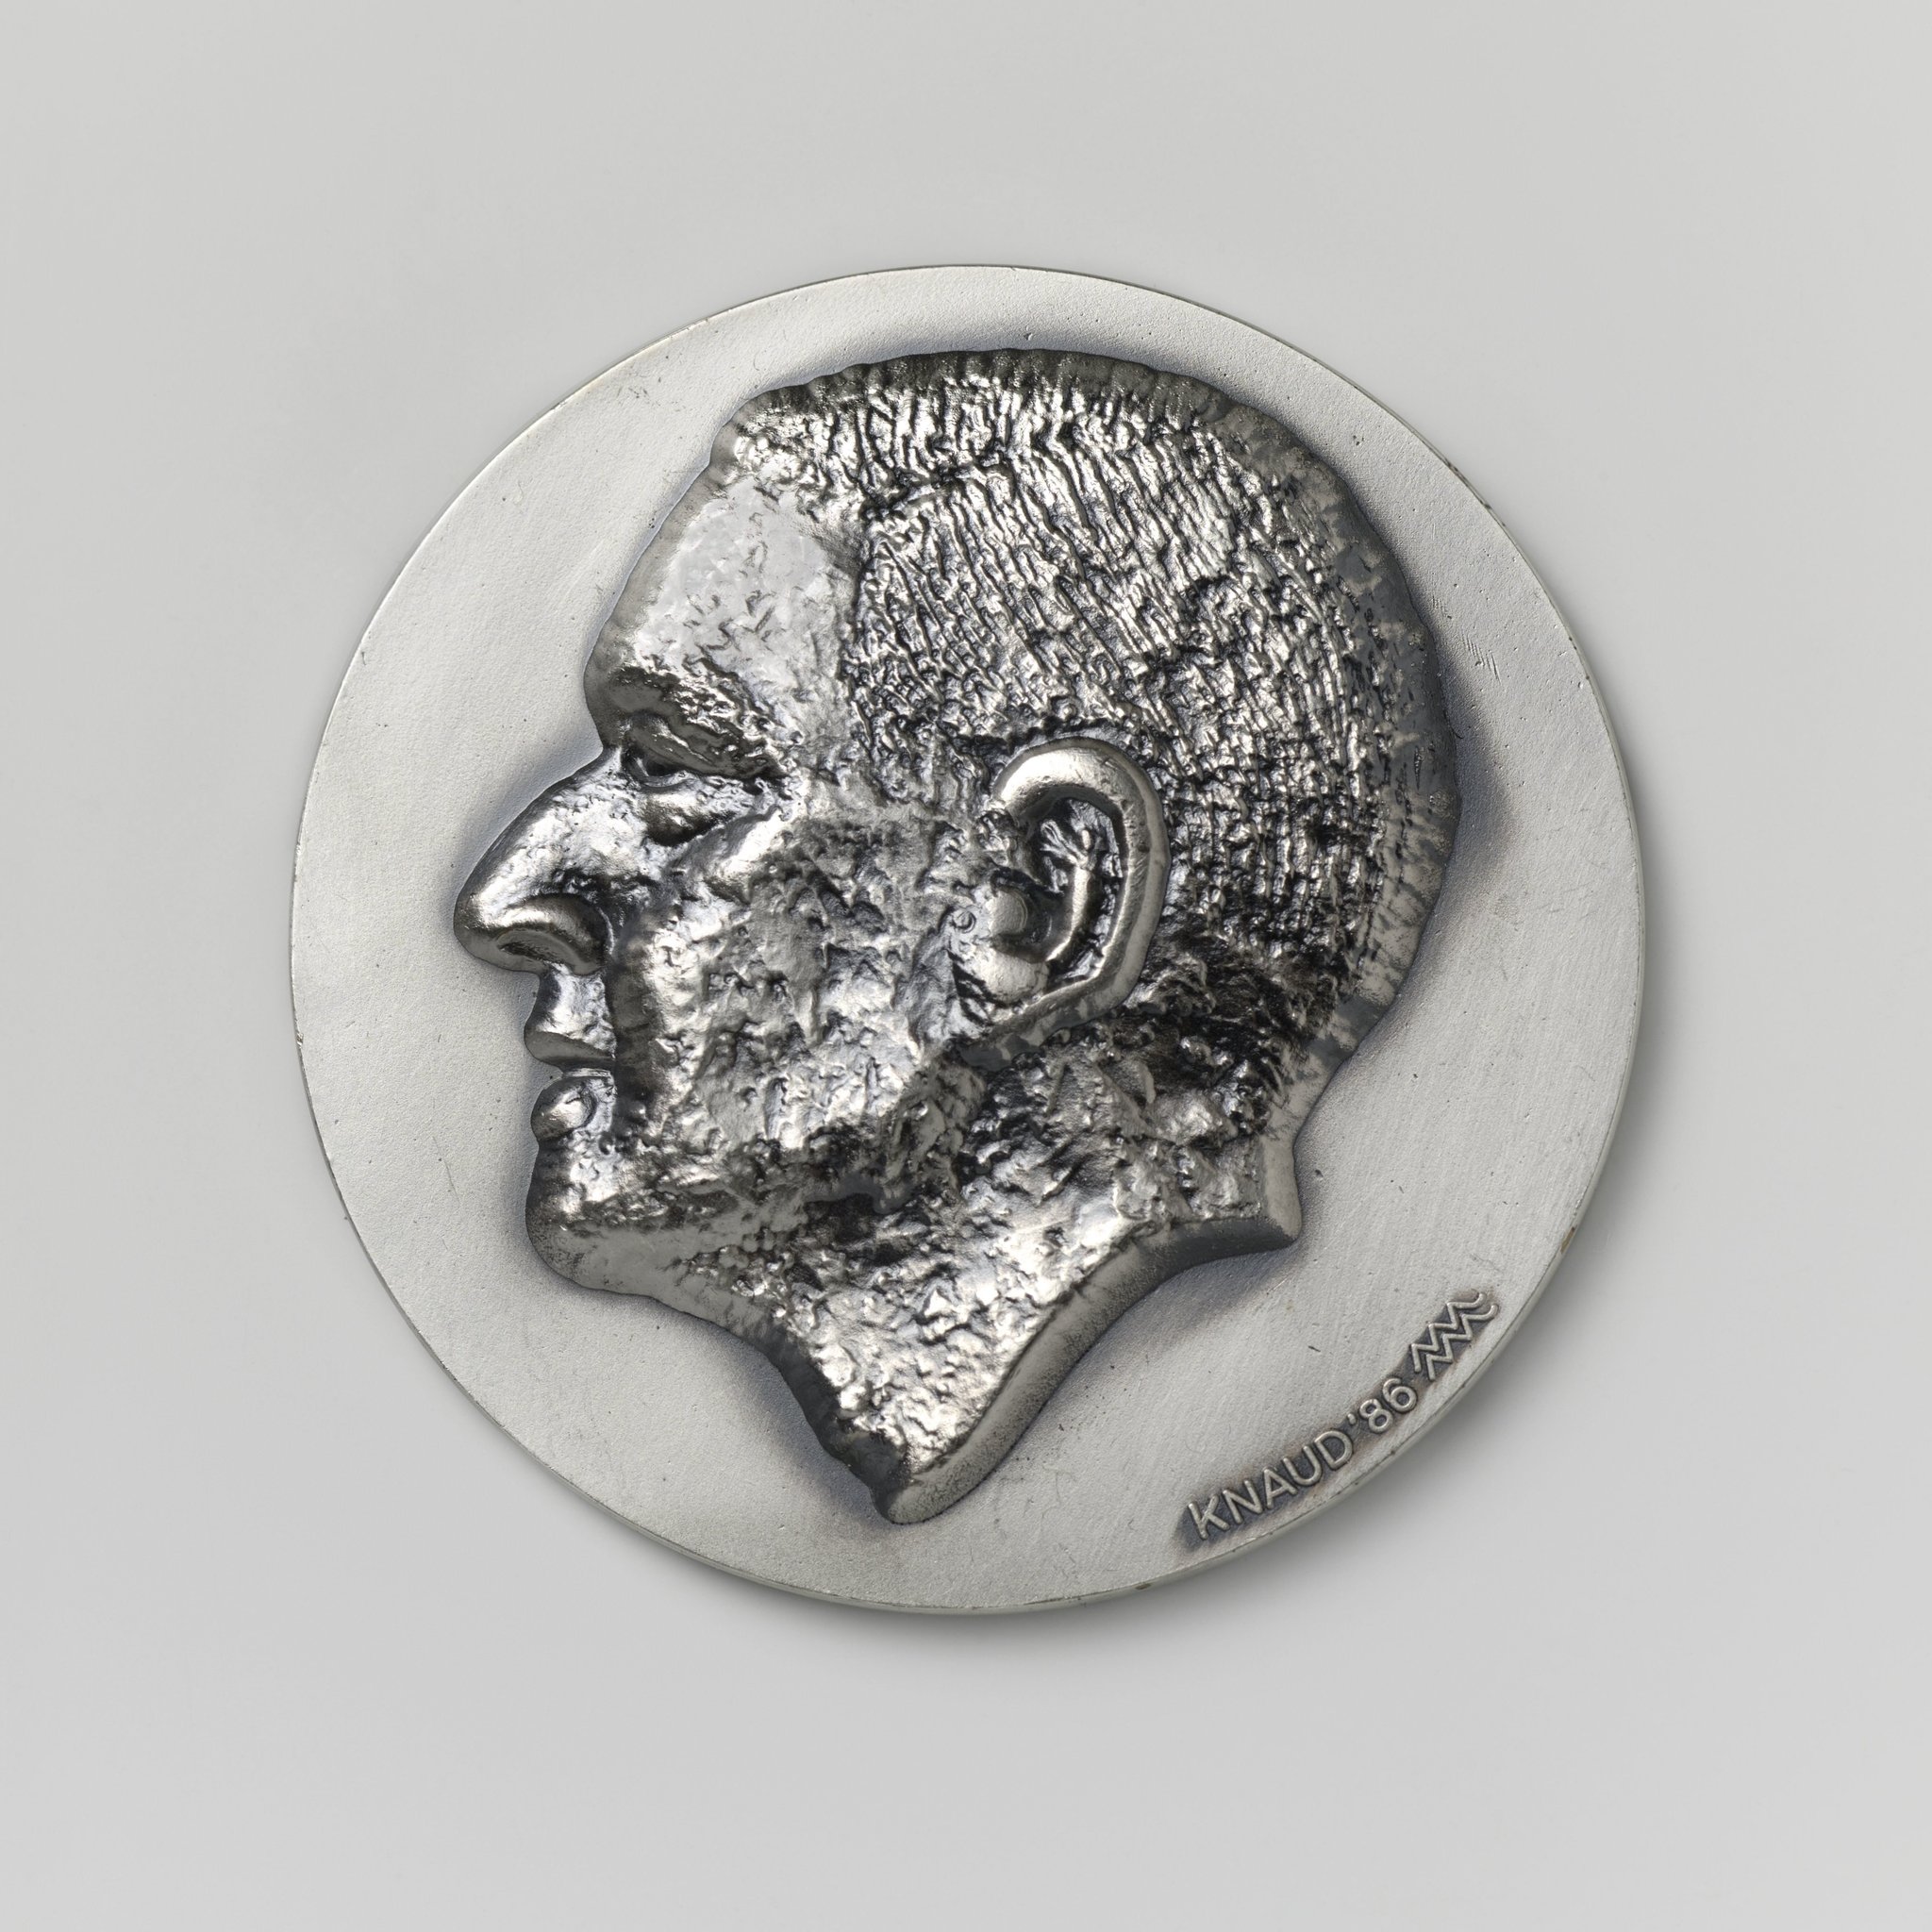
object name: document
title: Document bij penning A.W.L. Tjarda van Starkenborgh Stachouwer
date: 1986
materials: ink, paper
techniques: folding, printing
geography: zeist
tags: politician, dutch east indies, the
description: Document met eerbetoon aan A.W.L. Tjarda van Starkenborgh Stachouwer als laatste gouverneur-generaal van Nederlands-Indië. Tweezijdig gedrukt in bruin op crèmekleurig papier en 2 maal gevouwen.